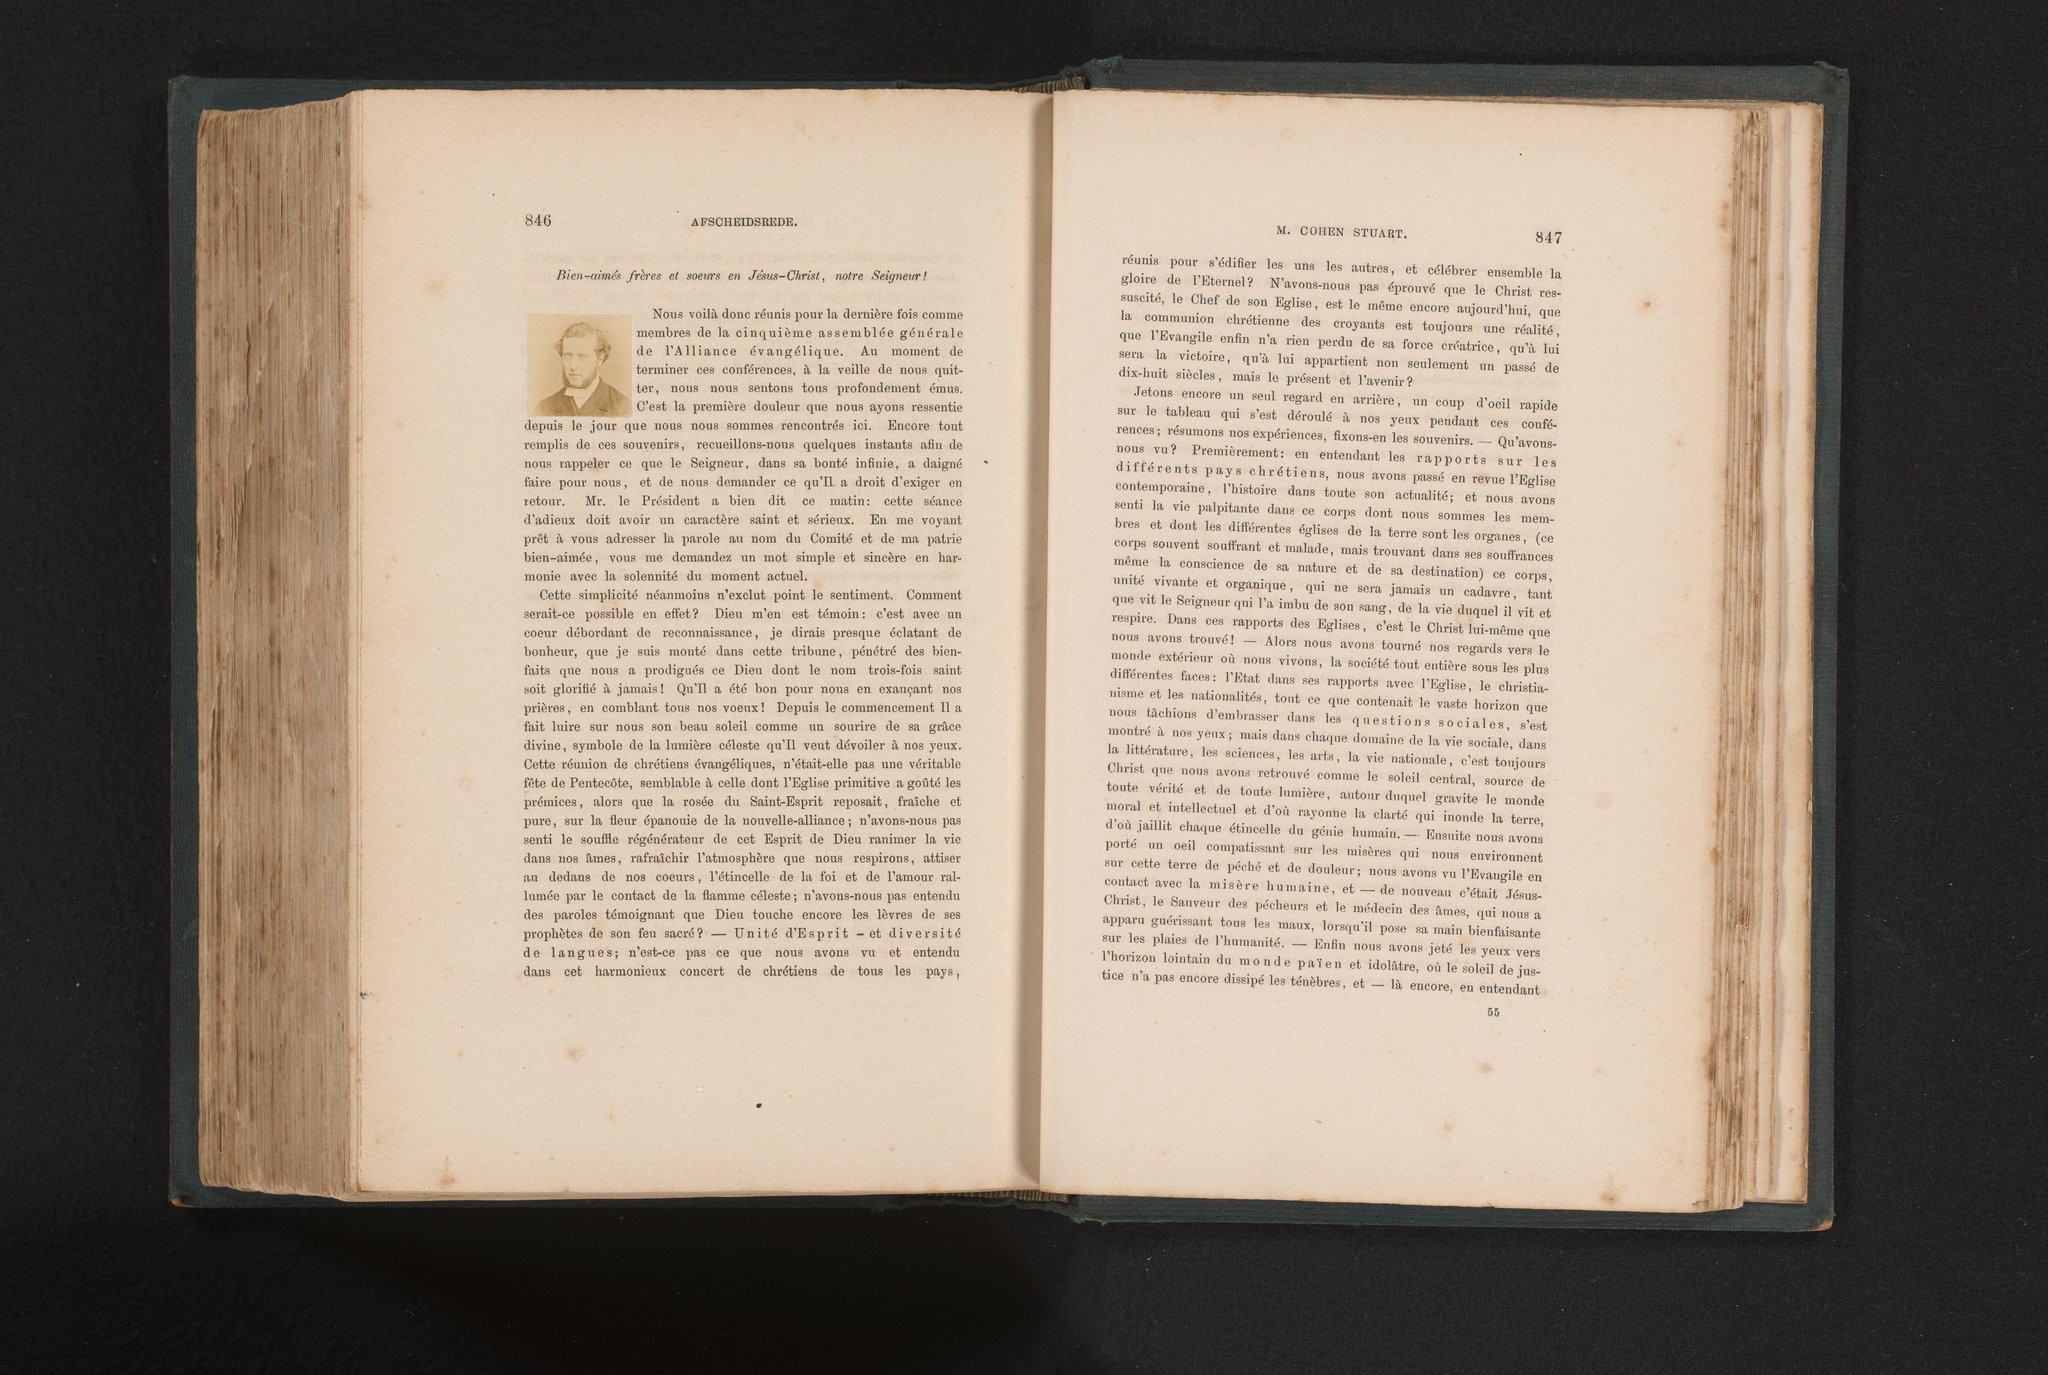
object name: photograph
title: Portret van Martinus Cohen Stuart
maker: Anonymous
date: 1855-1867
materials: paper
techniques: albumen print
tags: the hague, utrecht, martinus cohen stuart, adult man, historical persons